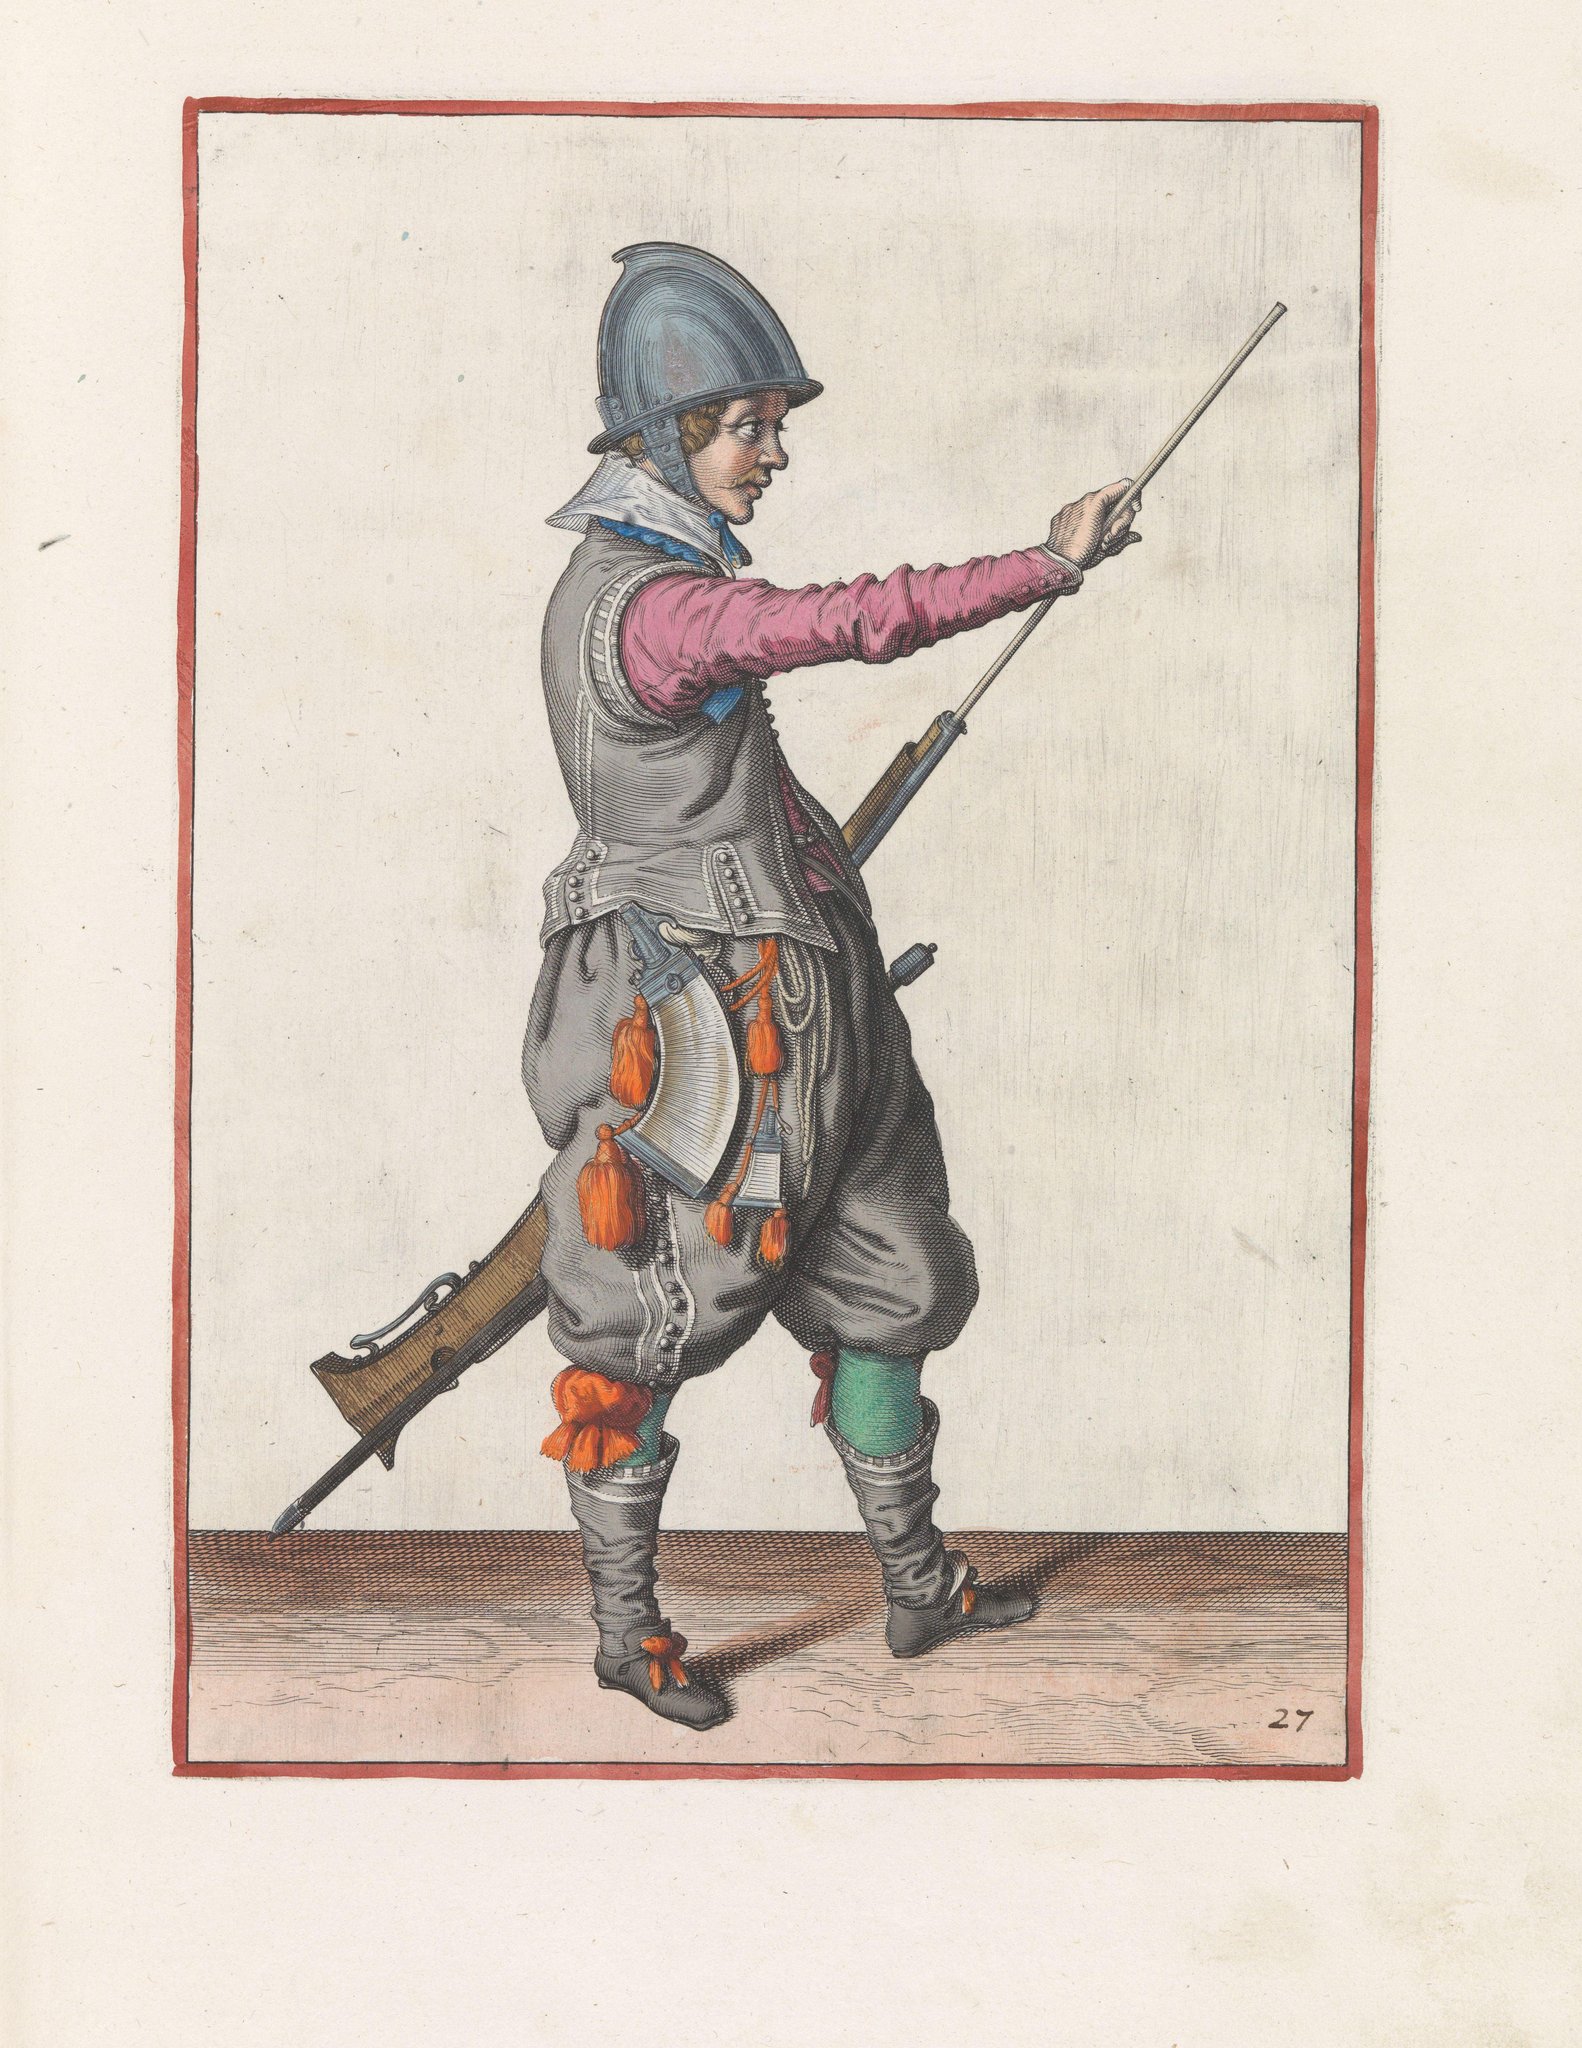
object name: print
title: Corte onderwysinghe op de figuerliicke afbeeldinghe, belanghende t'rechte ghebruyck des Roers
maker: jacques de gheyn (ii)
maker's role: painter, print maker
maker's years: 1565-1629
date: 1597-1607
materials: paper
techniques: engraving, hand coloring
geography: the hague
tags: handling of weapons ~ military training, firearms: rifle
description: Een soldaat, ten voeten uit, naar rechts, die met zijn linkerhand bij zijn linkerdijbeen een roer (een bepaald type vuurwapen) vasthoudt en met zijn rechterhand zijn laadstok uit de loop trekt. Deze prent is onderdeel van de reeks van 42 met de hand genummerde prenten van roerschutters in de Wapenhandelinghe.